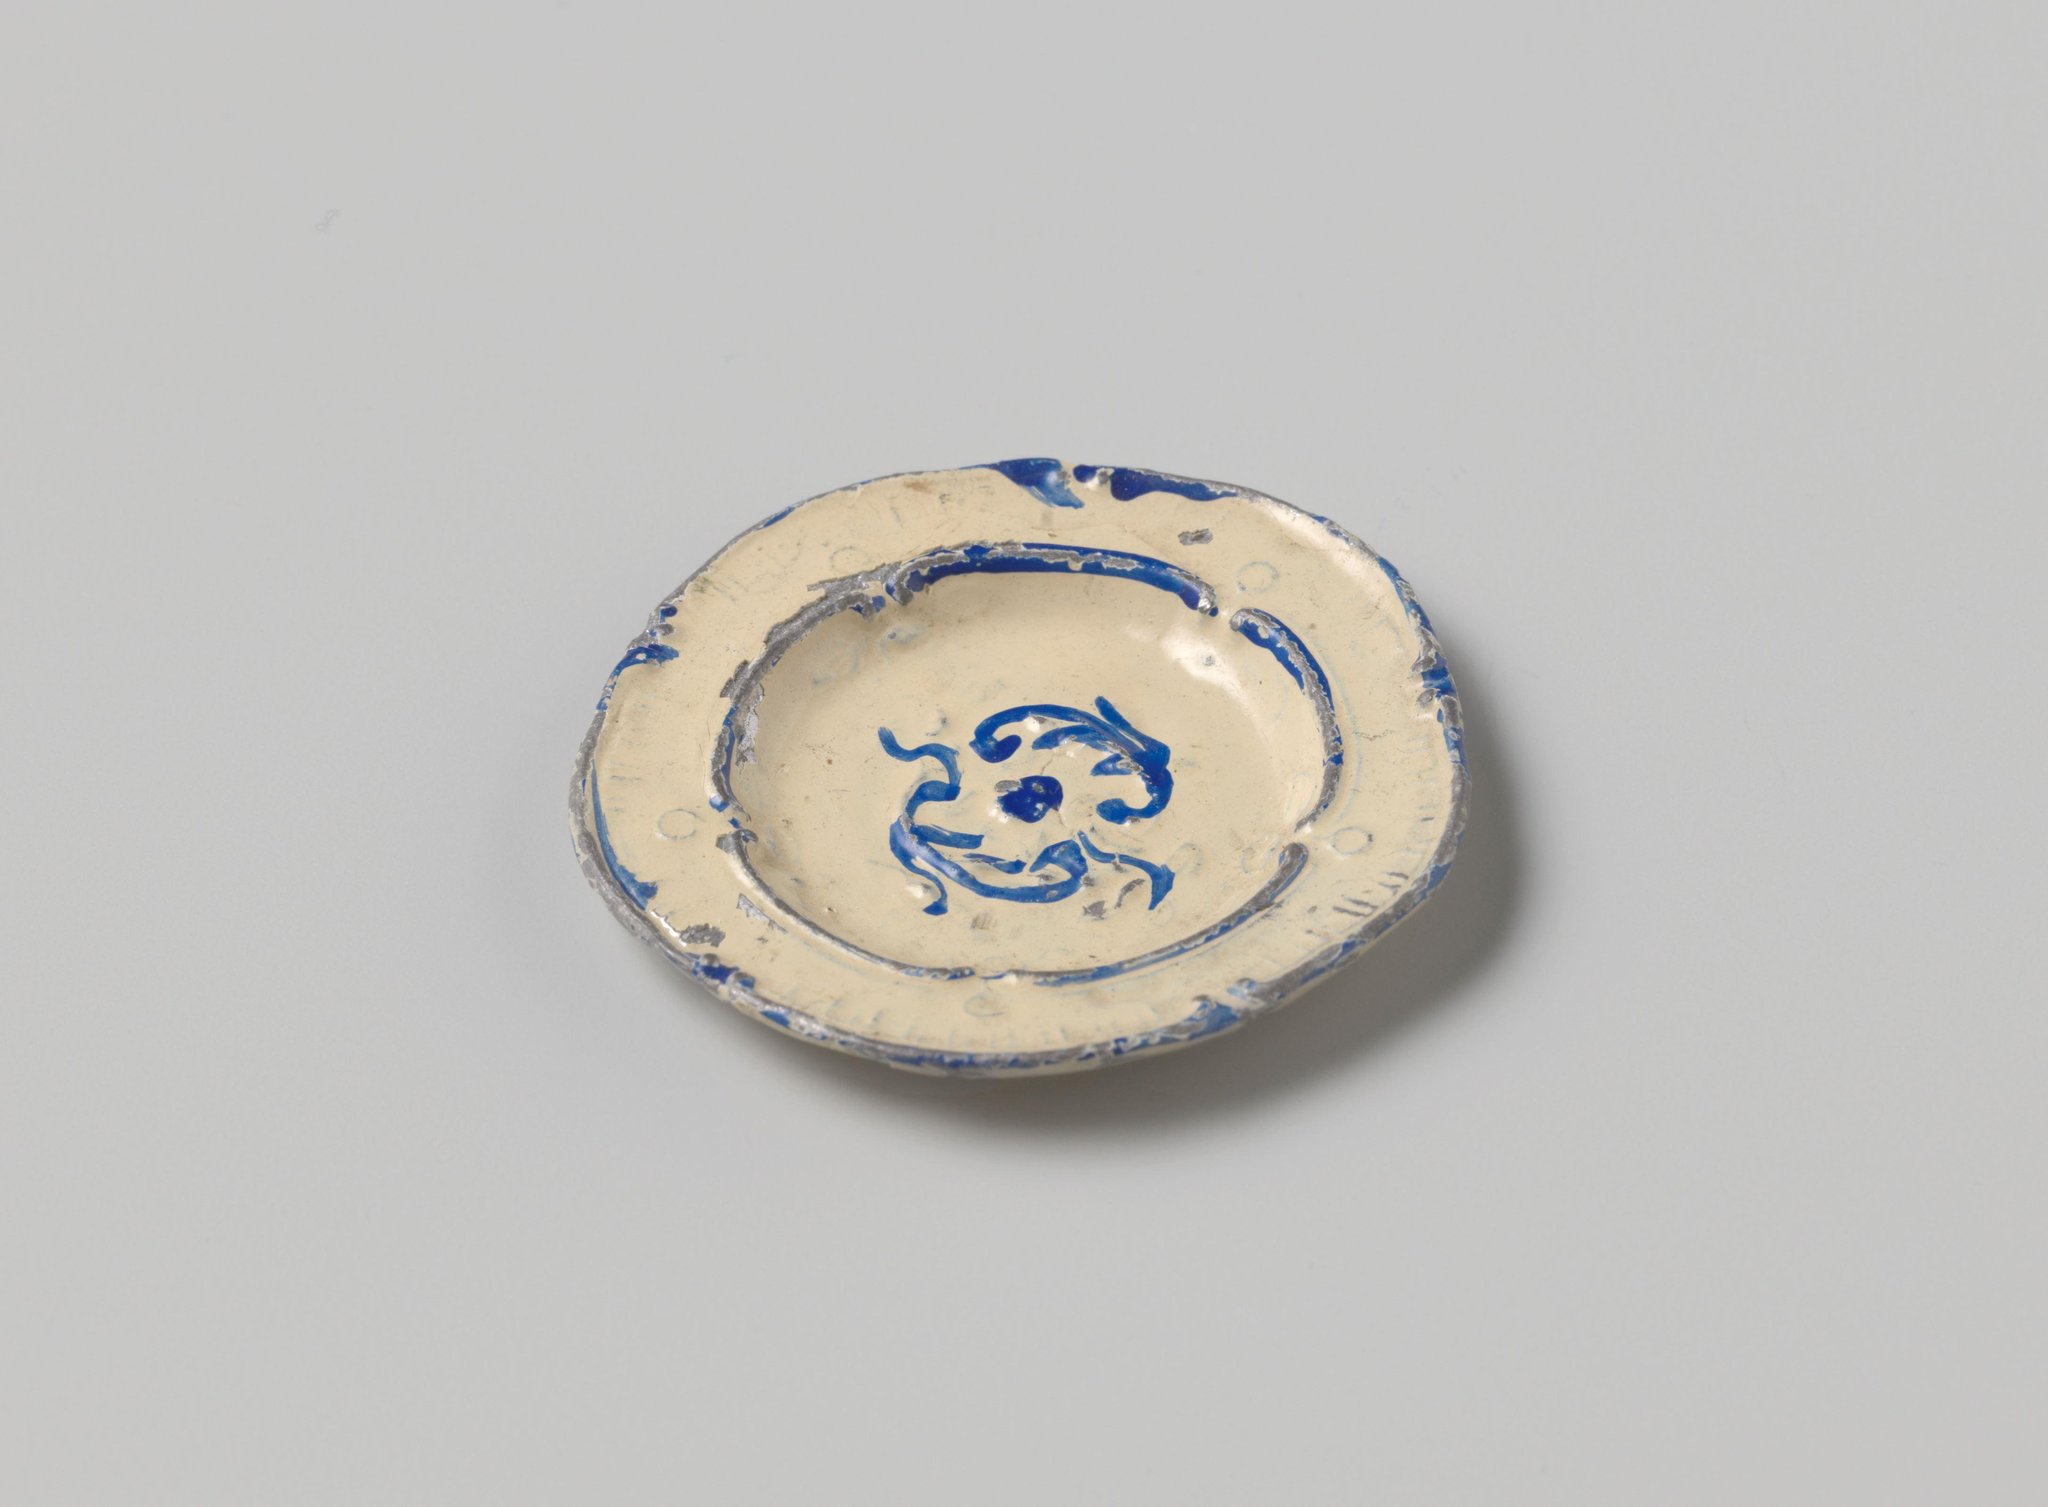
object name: plate dish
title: Miniatuur bord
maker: Anonymous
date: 1400-1950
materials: earthenware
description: Minatuur bord versierd met blauw krullende motieven.